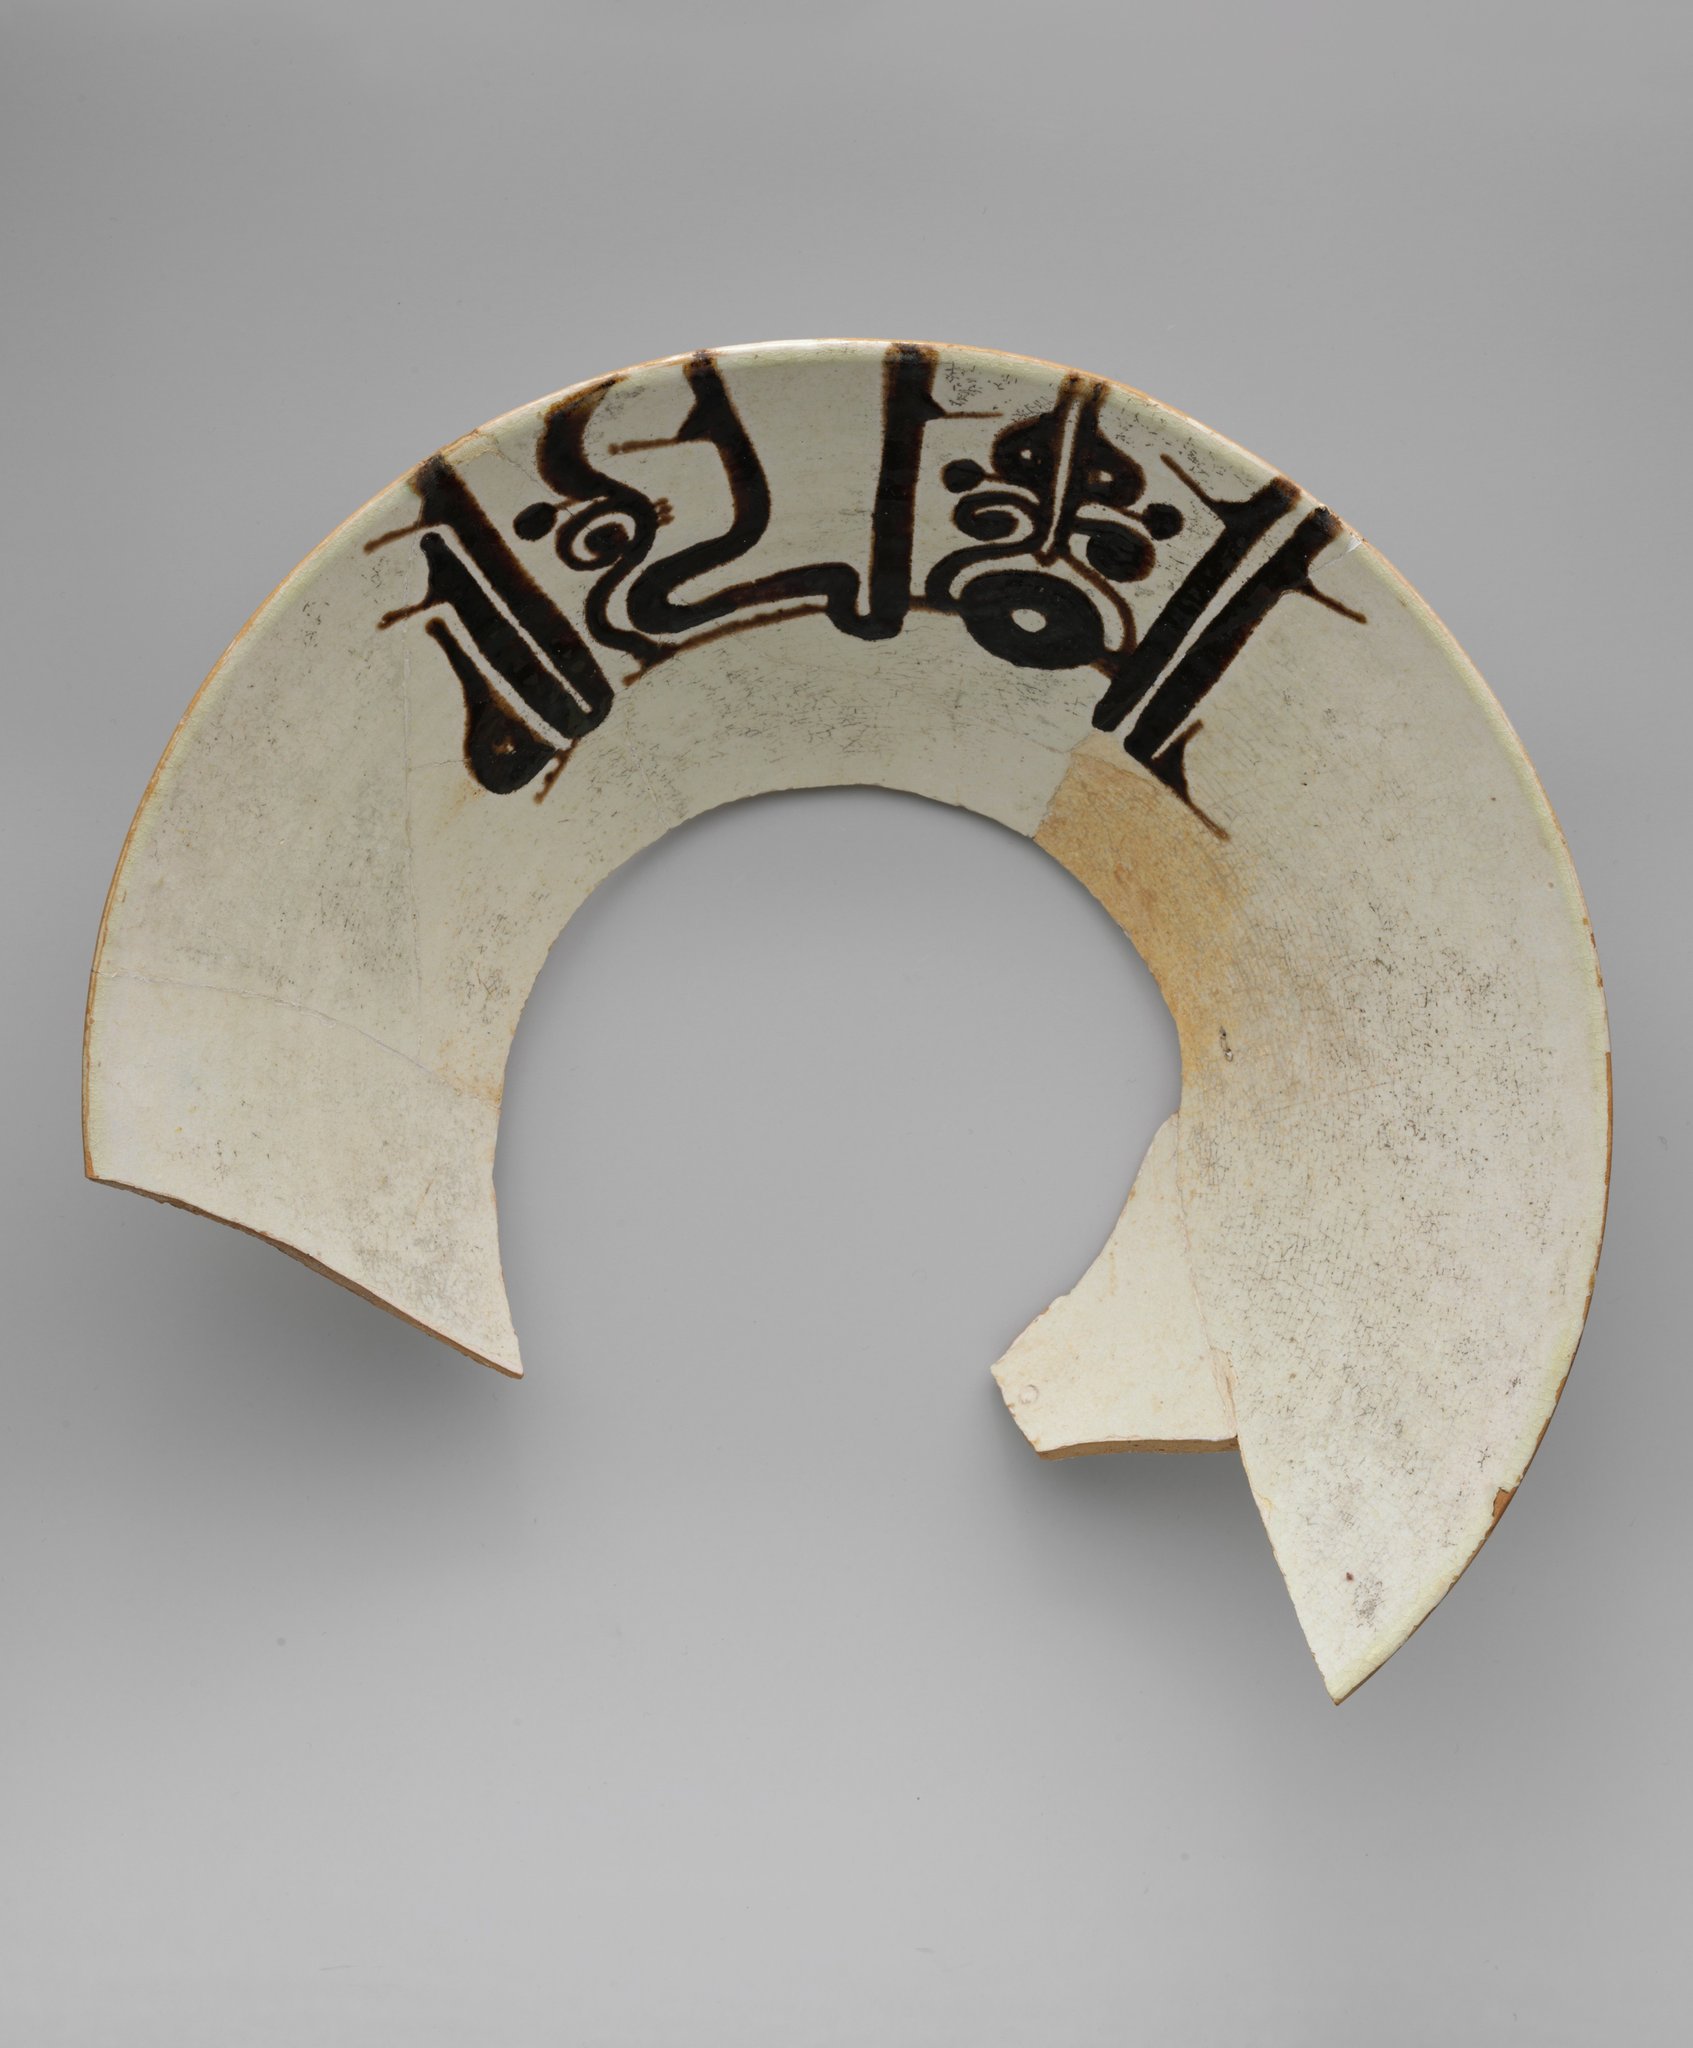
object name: bowl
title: Bowl with Inscription, "Sovereignty is God's"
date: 867-933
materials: earthenware, glaze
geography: iran